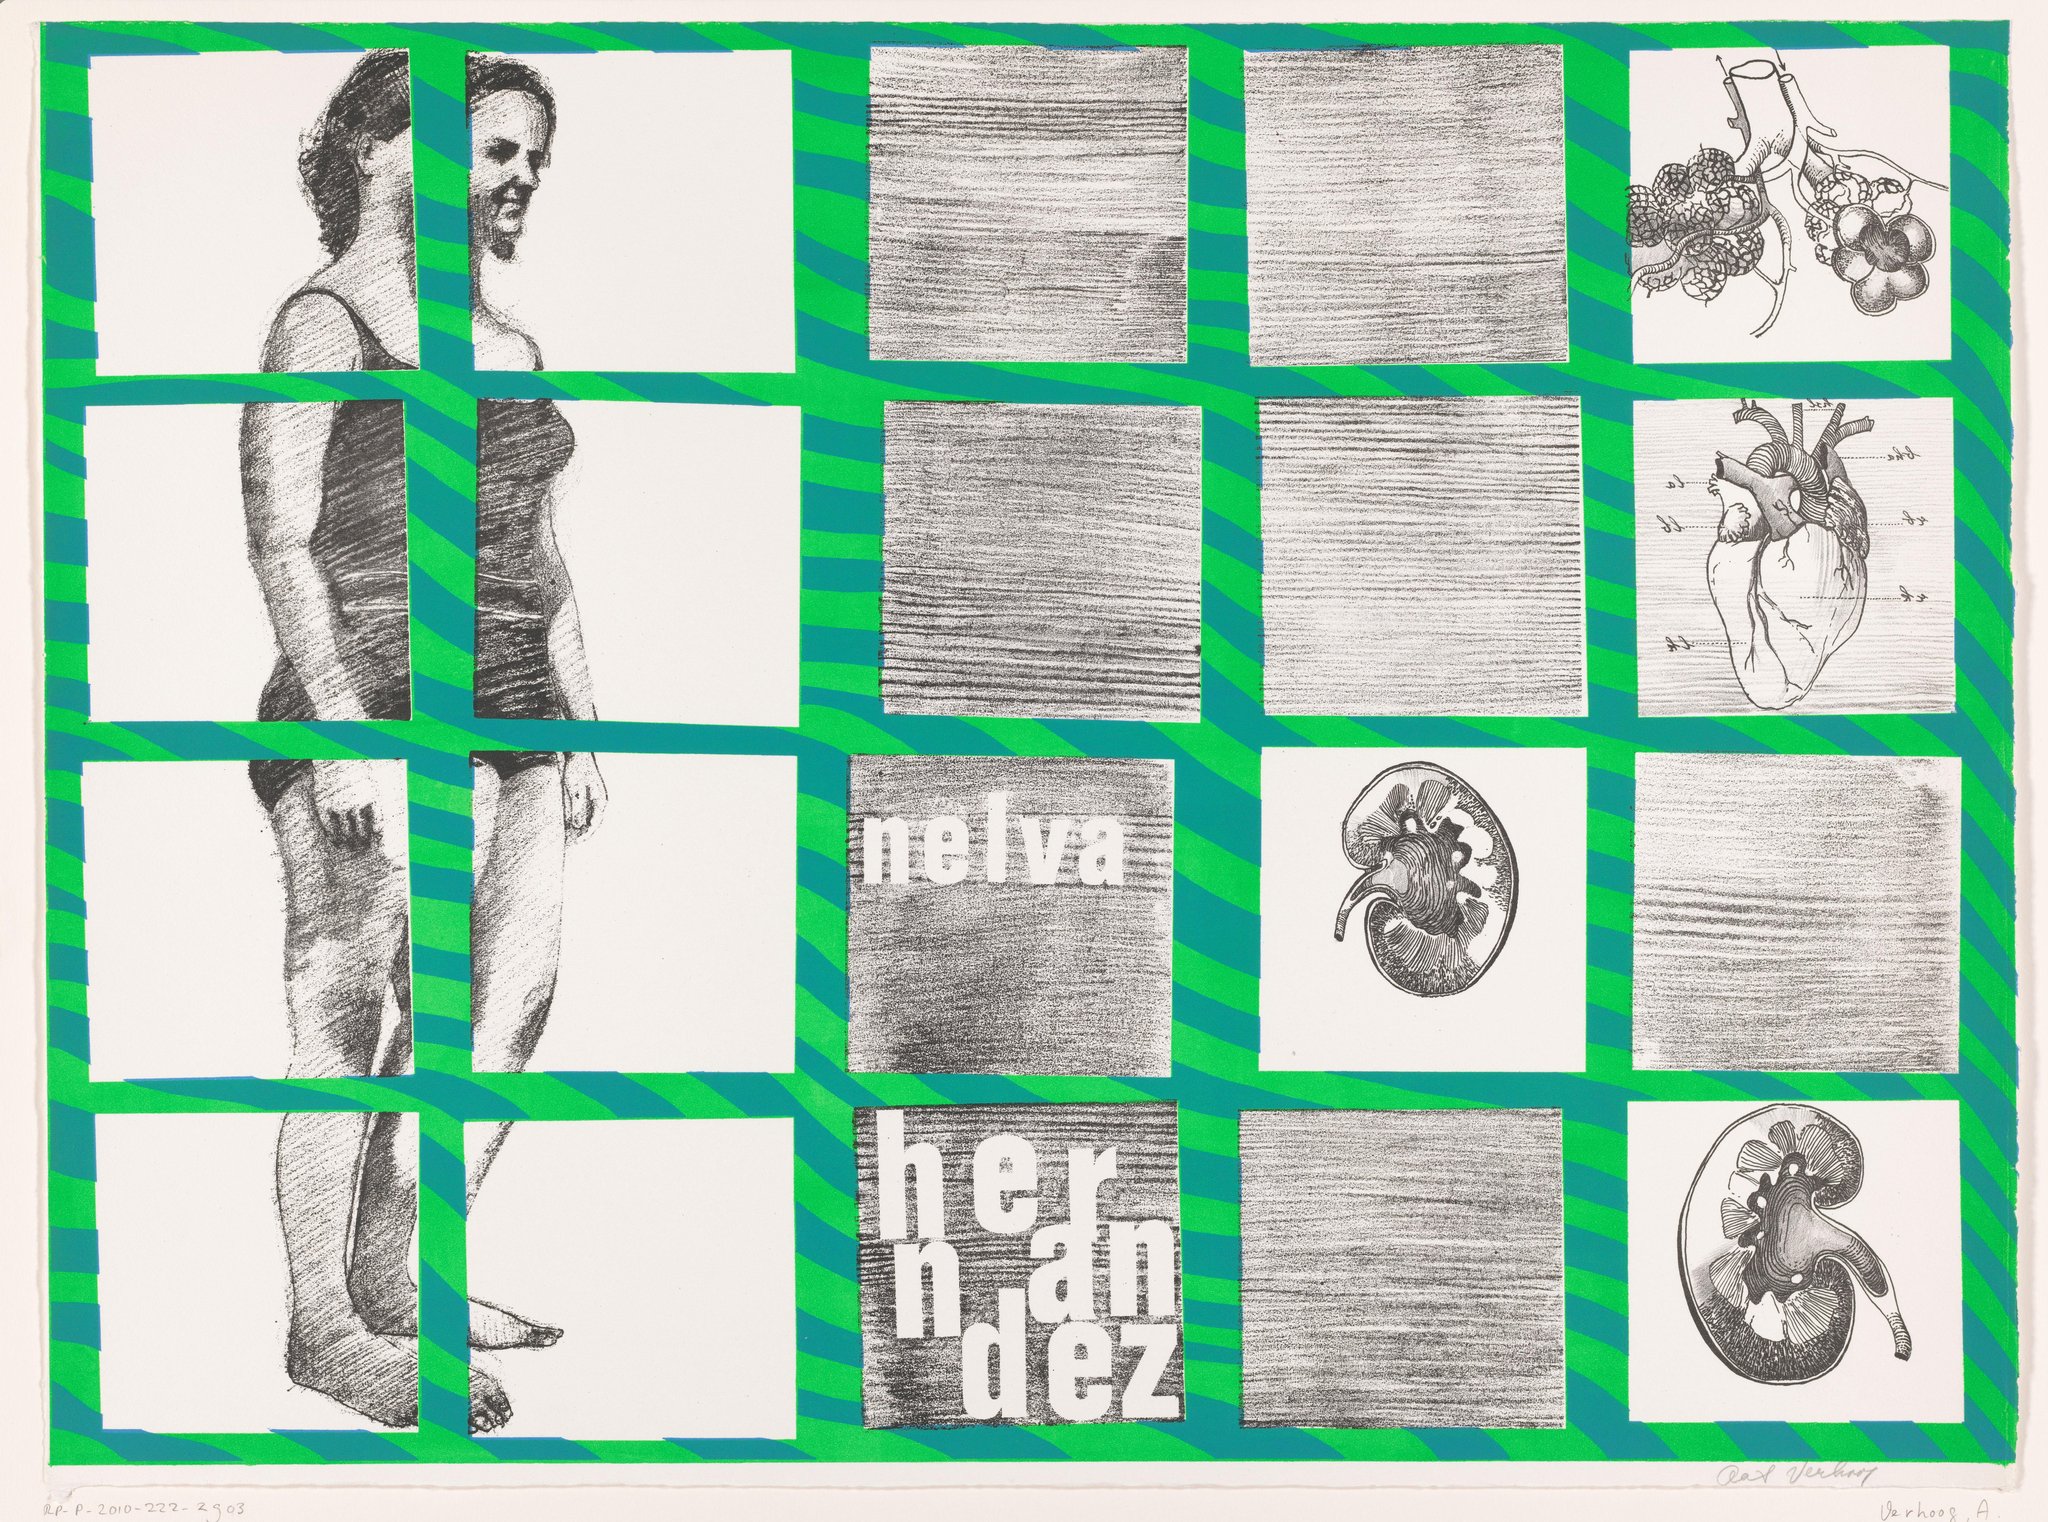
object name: print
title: Nelva Hernandez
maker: aat verhoog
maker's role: print maker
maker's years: 1933-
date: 1965-2009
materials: paper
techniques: lithograph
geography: netherlands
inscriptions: signature: ‘Aat Verhoog’, title: ‘nelva/ hernandez’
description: Staande vrouw in zwemkleding links en organen rechts. Voorstelling in fragmenten verdeeld over twintig witte vierkanten tegen groene achtergrond.